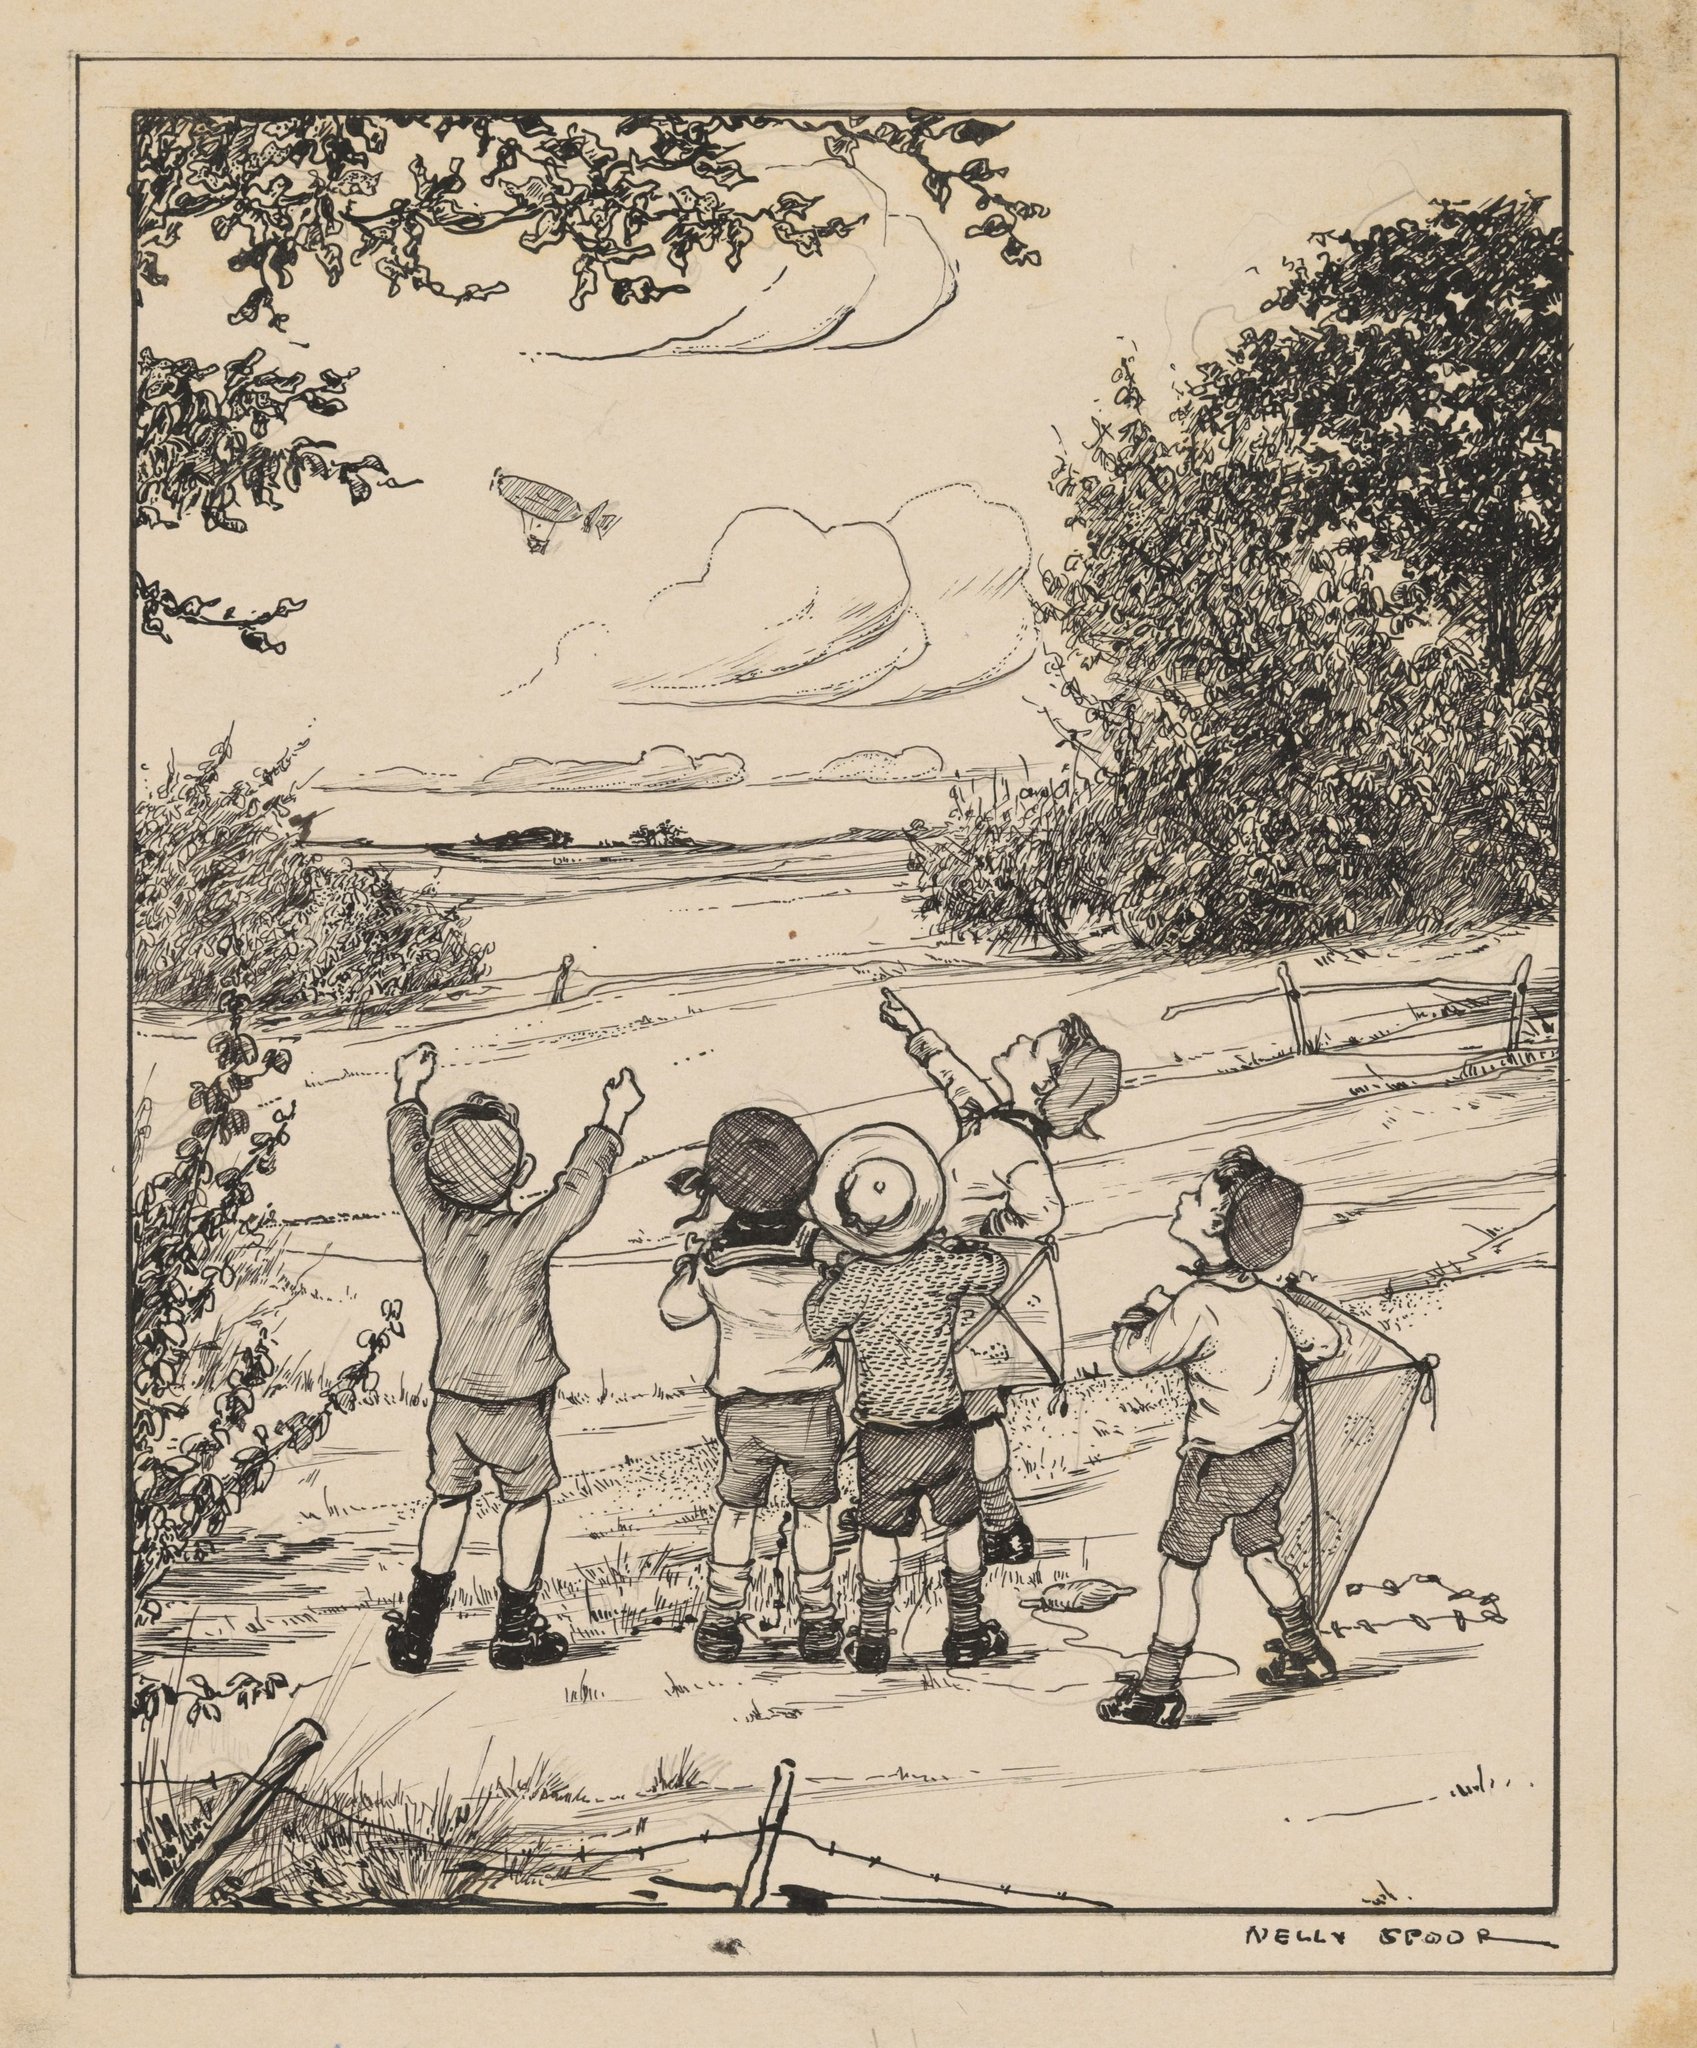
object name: drawing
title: Vijf jongens kijkend naar een zeppelin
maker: nelly spoor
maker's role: draughtsman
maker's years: 1885-1950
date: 1895-1950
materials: cardboard, ink, pencil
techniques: pen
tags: boy (child between toddler and youth), 46c35 airship, zeppelin, (flying a) kite, meadow, pasture (+ landscape with figures, staffage)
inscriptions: :, signature: ‘NELLY SPOOR’, collector's mark: Lugt 2228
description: In een weiland staan vijf jongens. Ze hebben twee vliegers bij zich en kijken en wijzen naar de lucht waar een zeppelin zweeft. Verso potloodstudies.